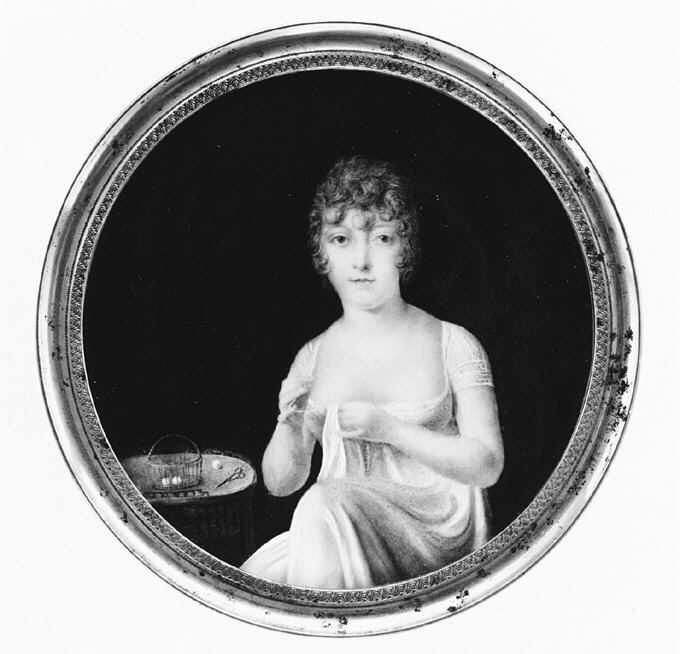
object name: painting, miniature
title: Madame Jean-Baptiste Isabey (Jeanne Laurice de Salienne, died 1829)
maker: jean-baptiste isabey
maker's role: artist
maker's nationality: french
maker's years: 1767-1855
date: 1796-1800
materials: ivory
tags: portraits,women,sewing